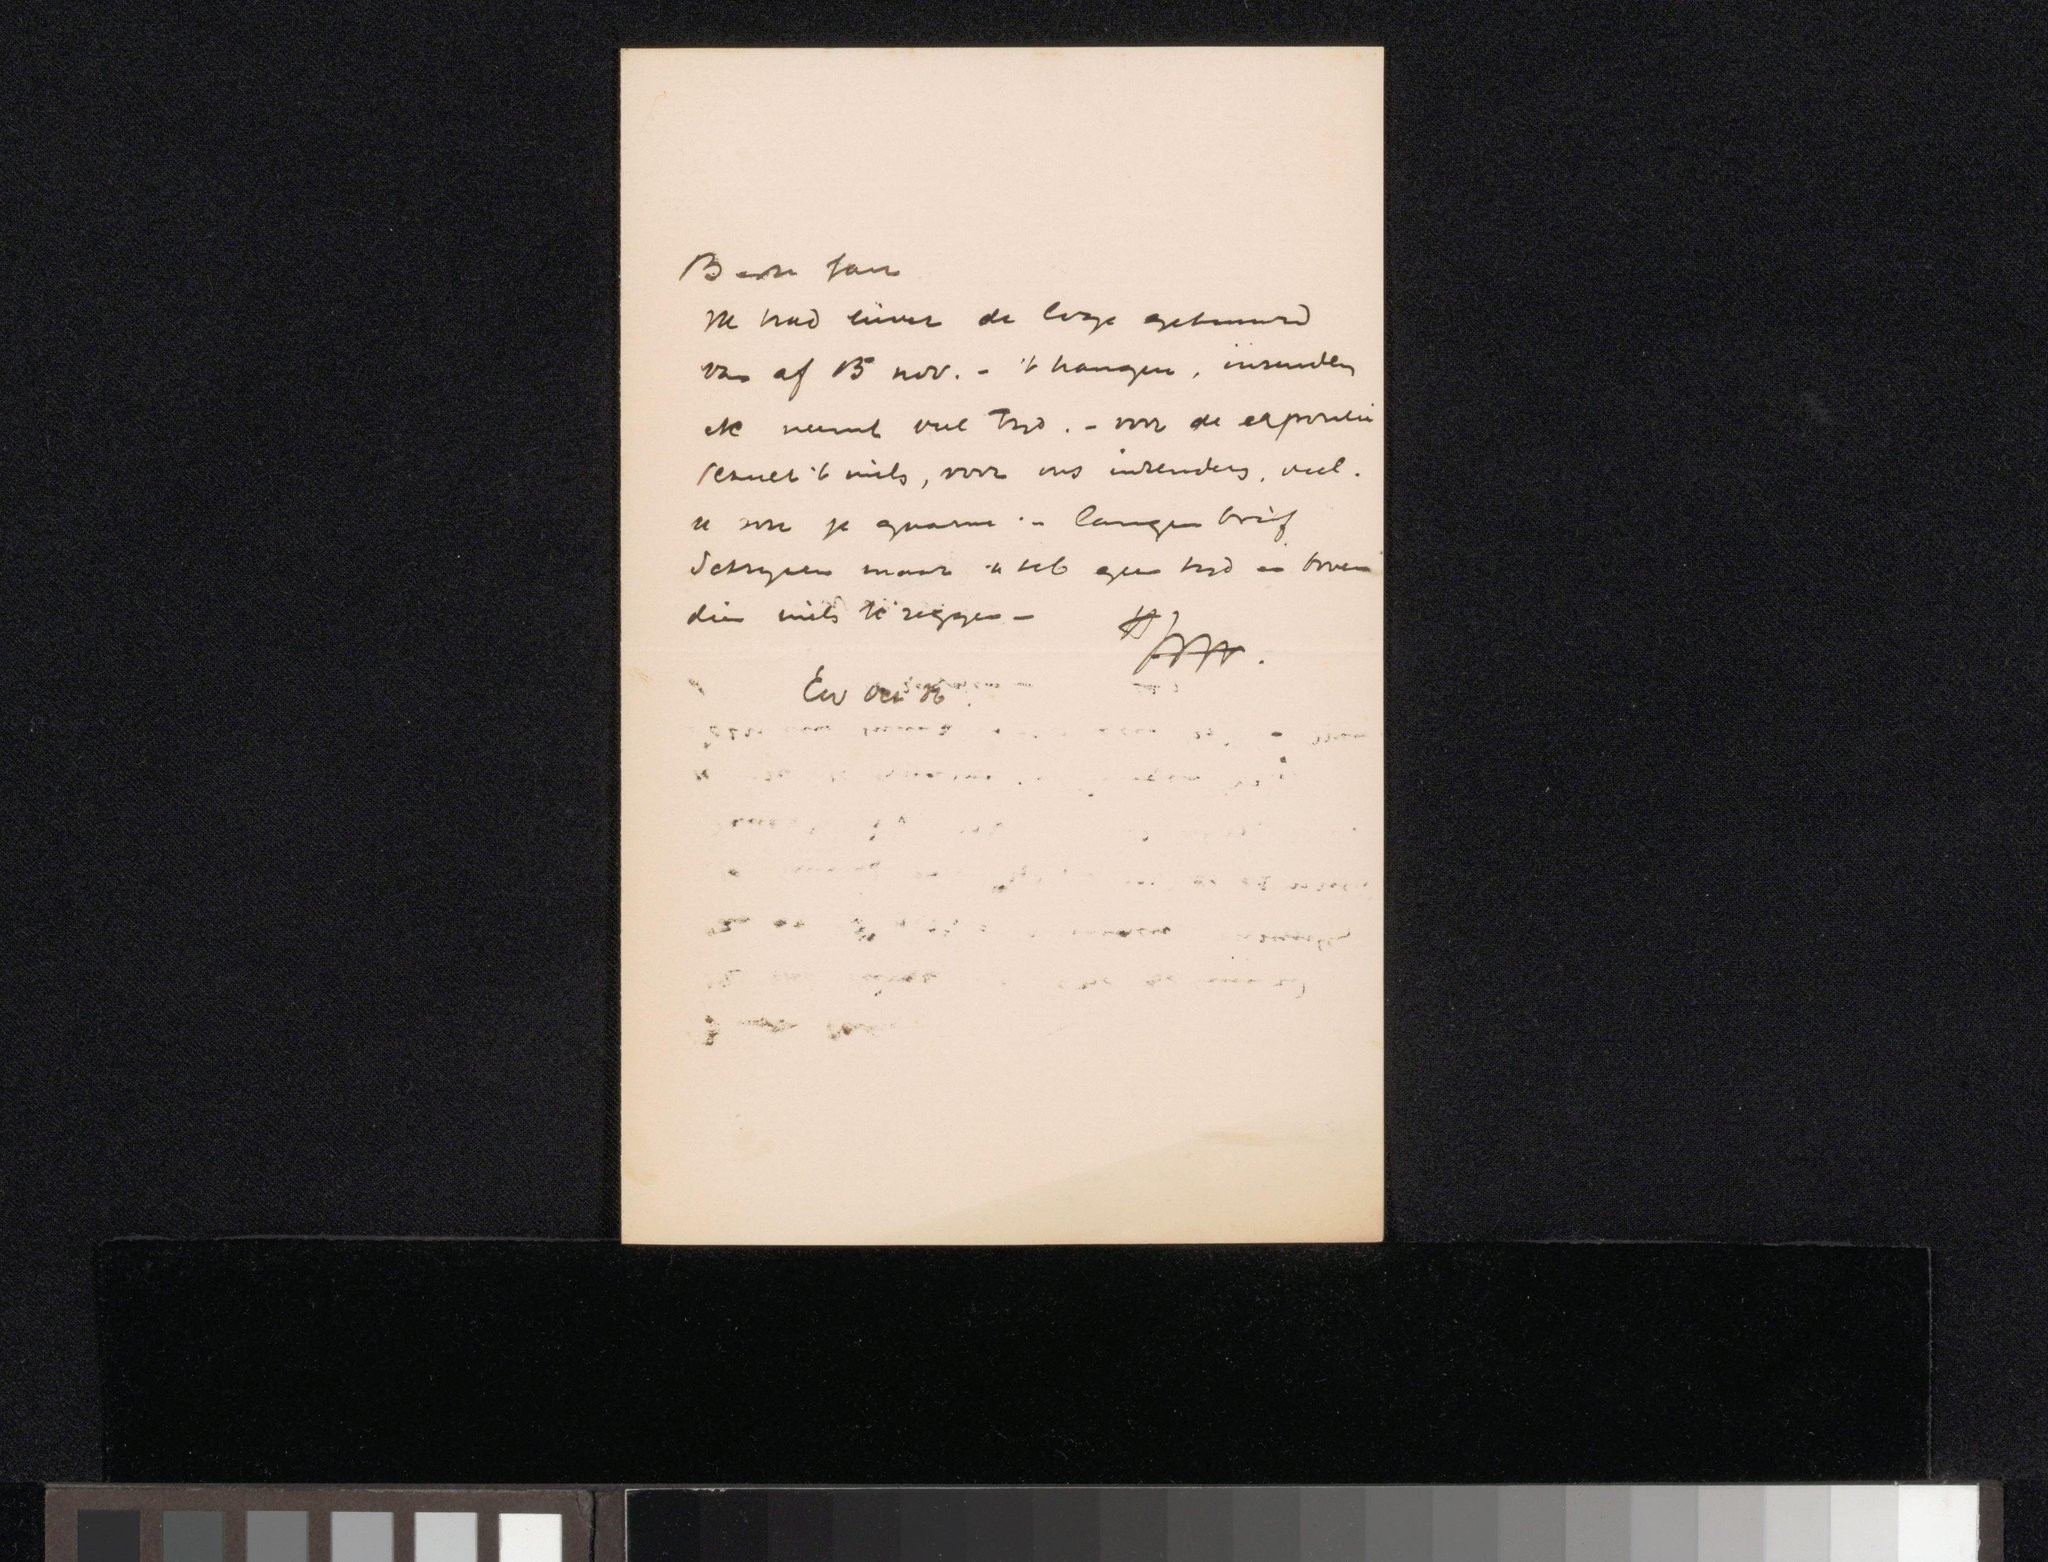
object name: letter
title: Brief aan Jan Veth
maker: willem witsen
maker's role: draughtsman, painter, print maker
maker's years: 1860-1923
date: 1810-1886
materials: ink, paper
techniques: pen, writing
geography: ewijkshoeve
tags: dordrecht, painter, print maker, draughtsman, designer, jan veth, exhibition ~ art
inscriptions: watermark, collector's mark: ‘RPK’